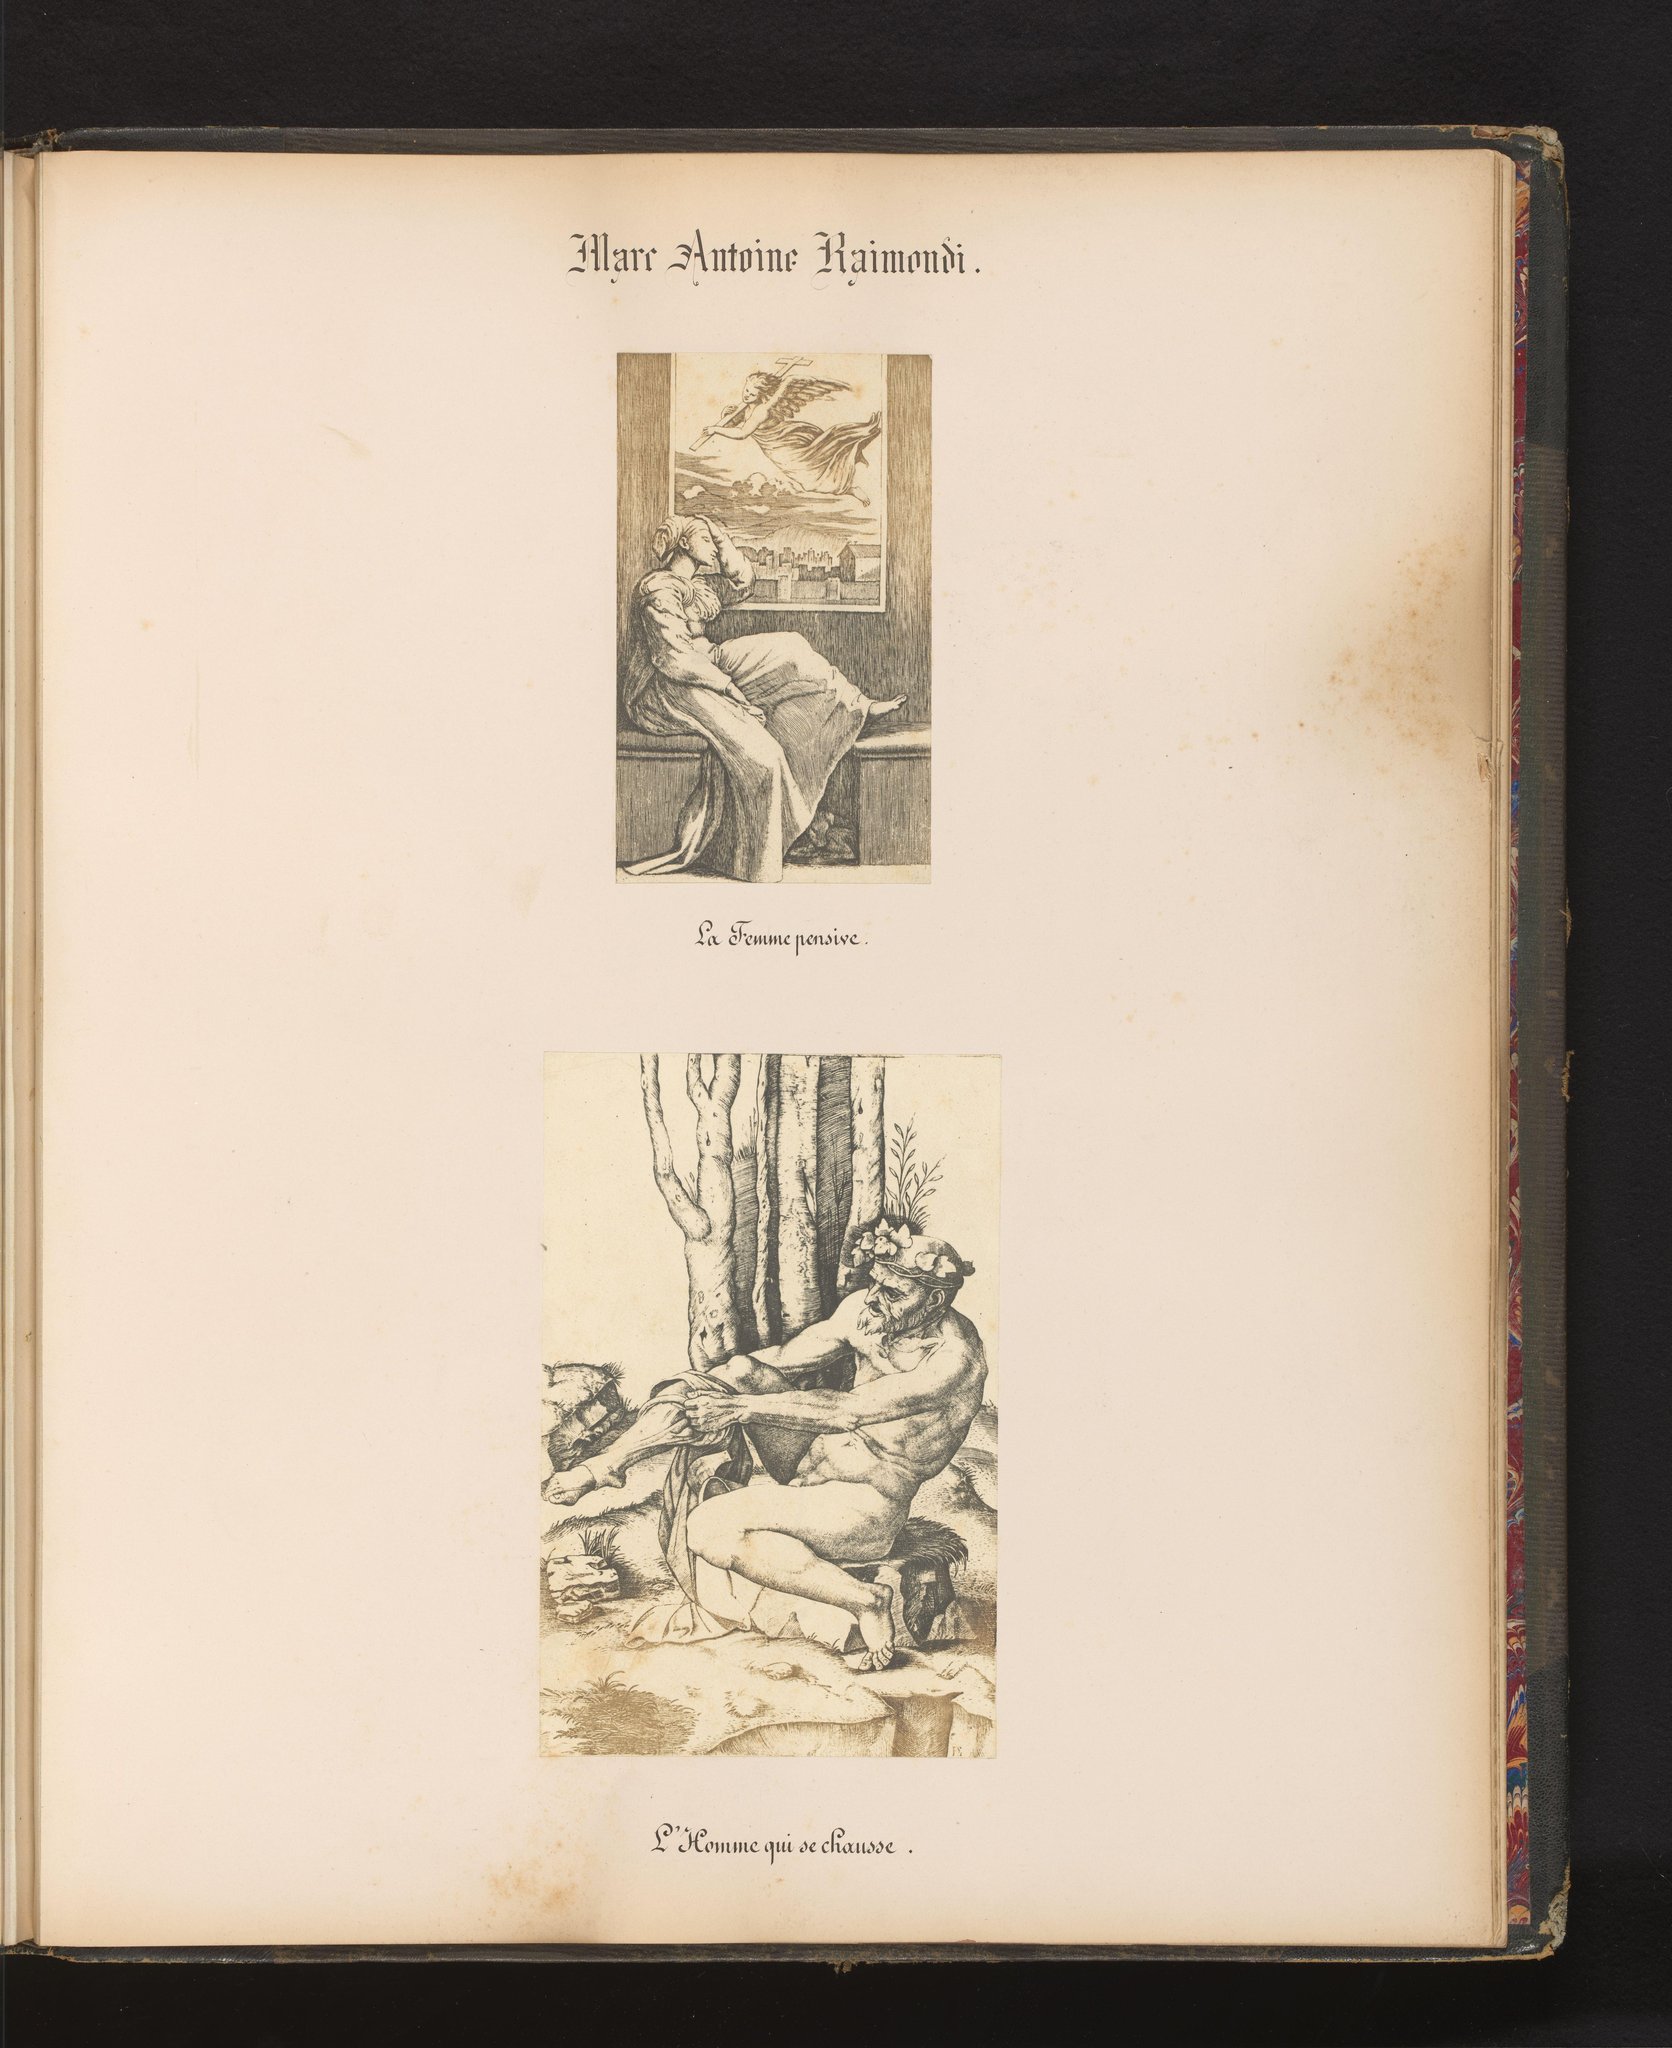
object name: photograph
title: La Femme pensive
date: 1848-1853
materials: photographic support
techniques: salted paper print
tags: adult woman, contemplation